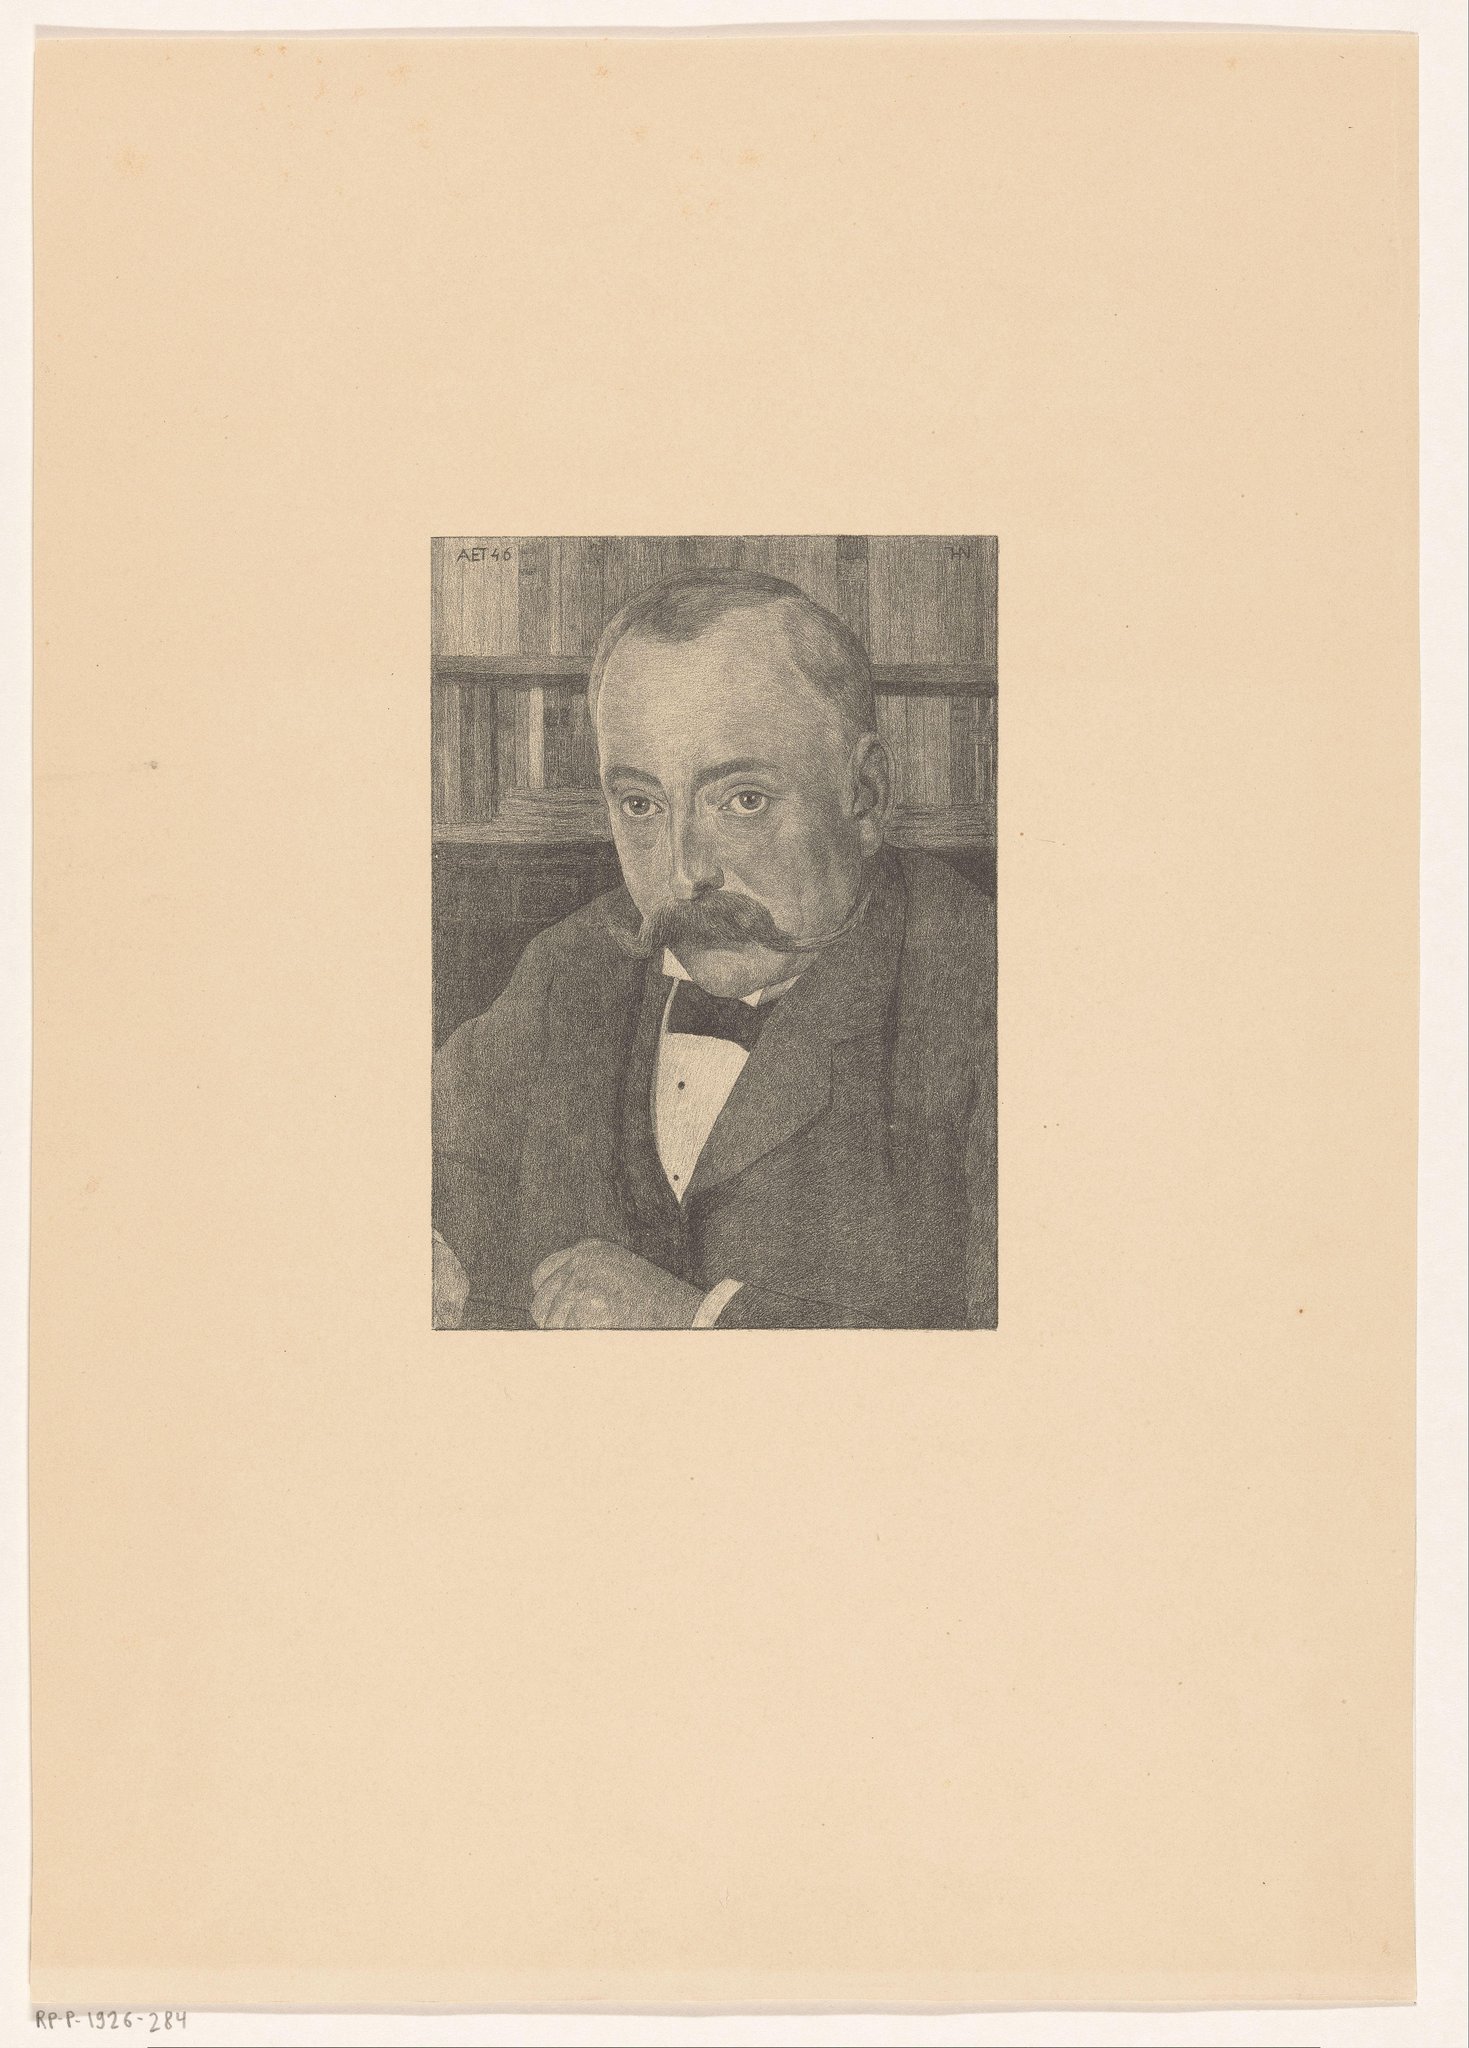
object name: print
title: Portret van een onbekende man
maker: ferdinand hart nibbrig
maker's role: draughtsman, painter, print maker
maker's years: 1866-1915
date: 1876-1915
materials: paper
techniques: lithograph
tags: anonymous historical person portrayed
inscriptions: collector's mark: Lugt 2228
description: De man heeft een snor. Op de achtergrond een boekenkast.